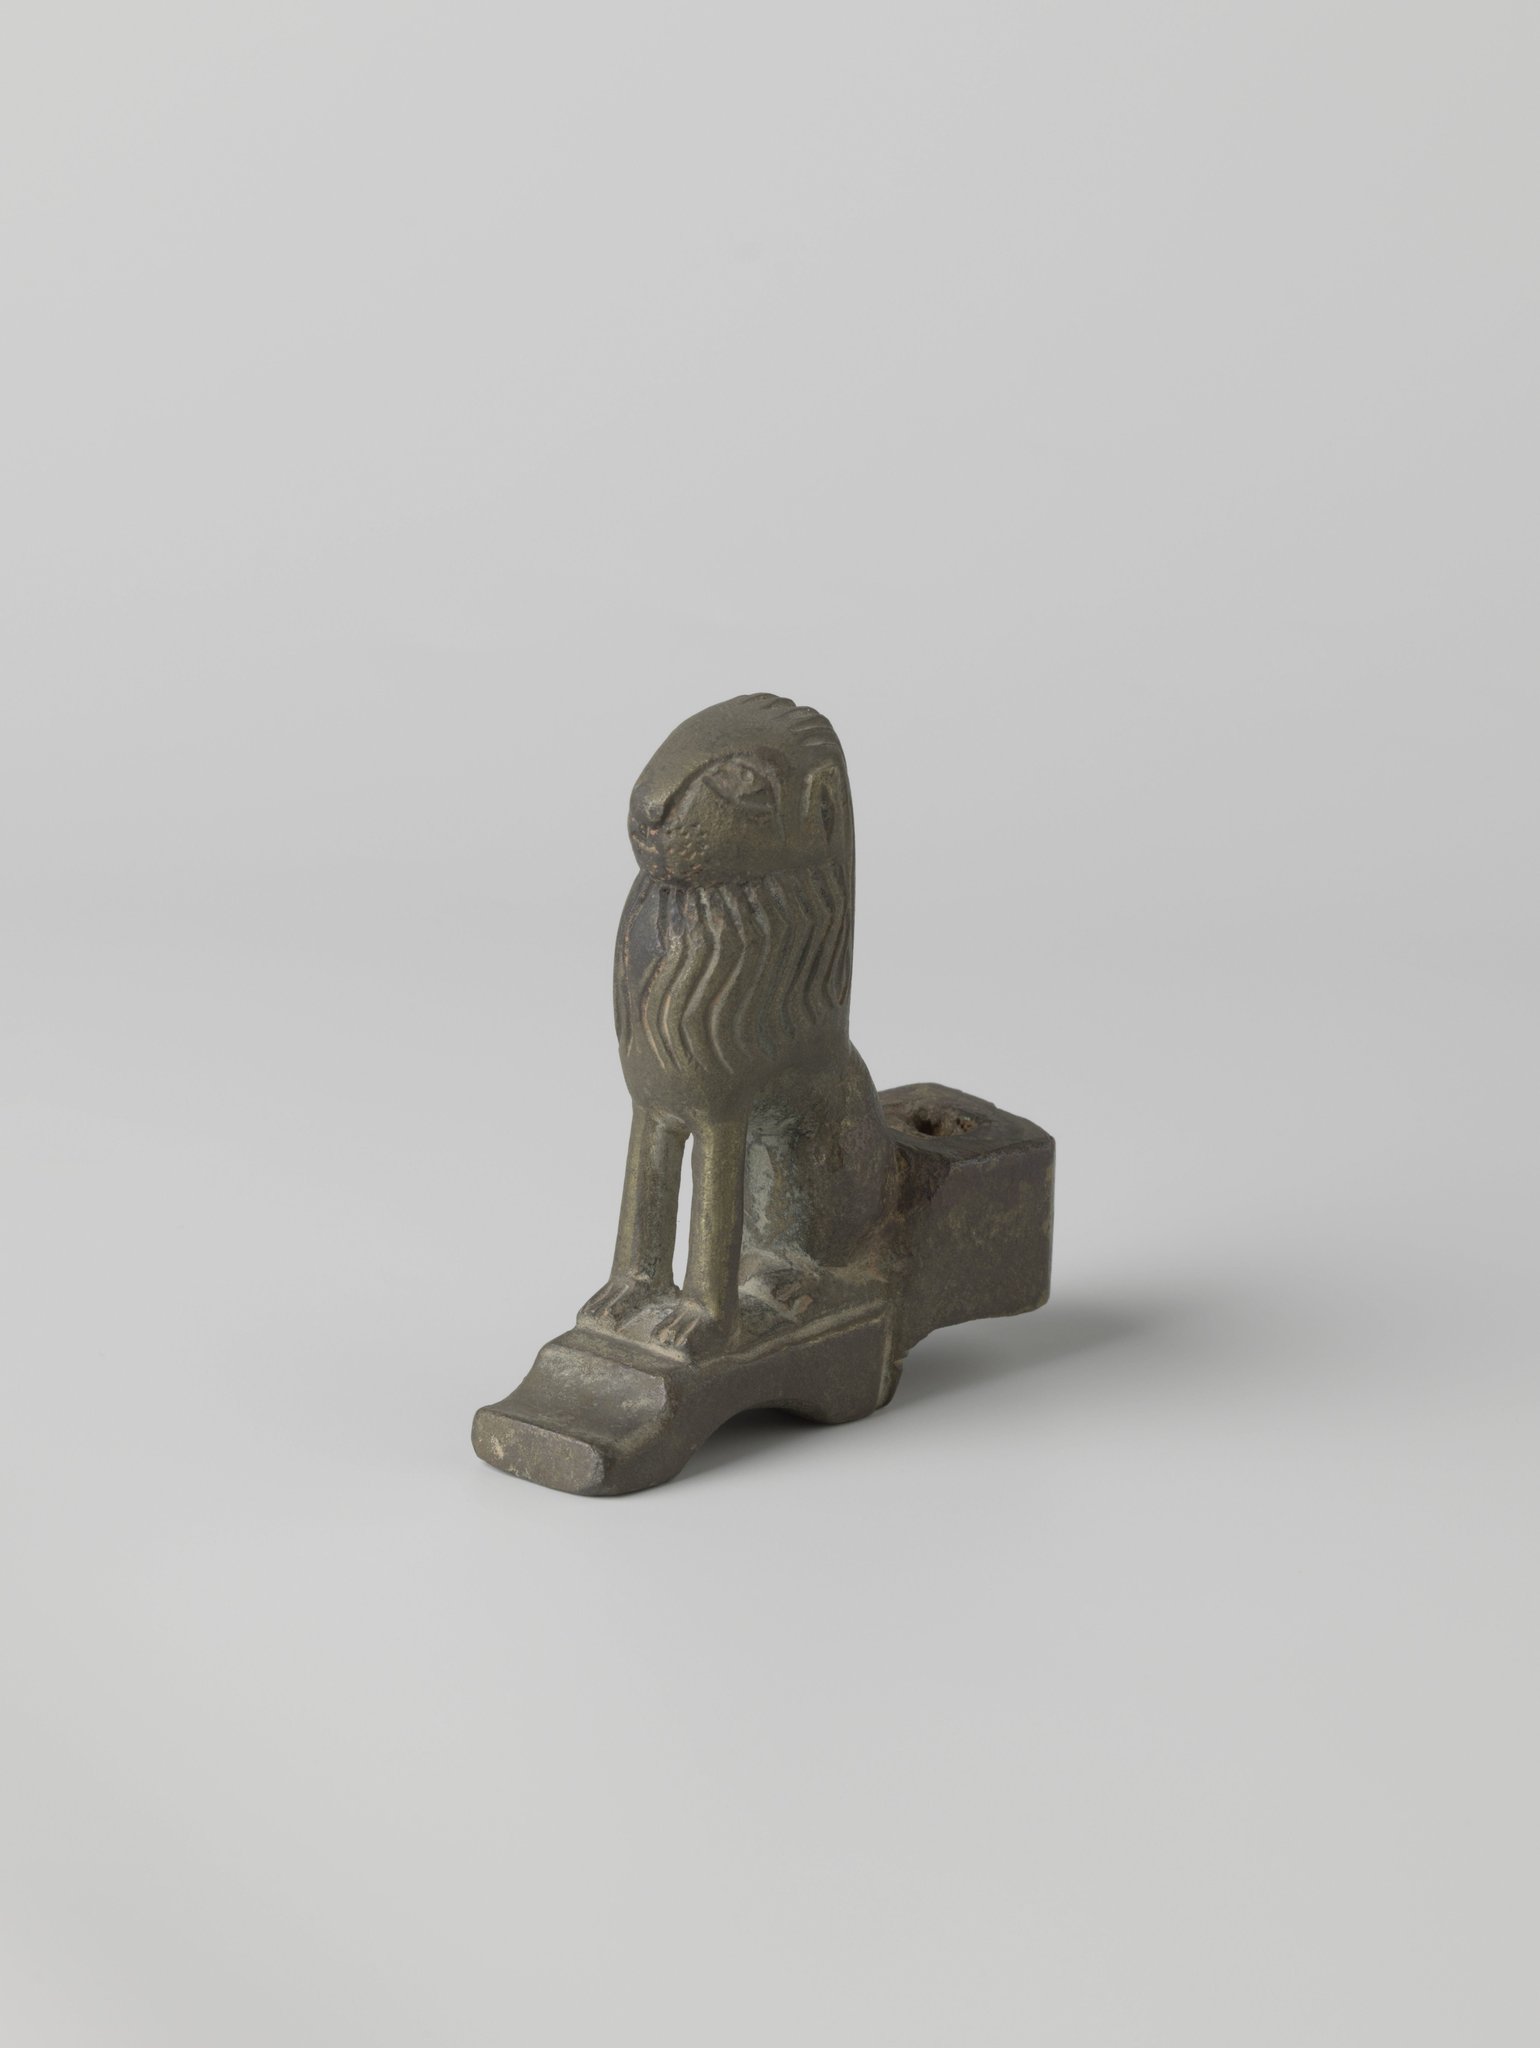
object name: candlestick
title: Voet van een kandelaar met zittende leeuw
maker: Anonymous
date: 1400-1500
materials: brass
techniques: casting, metalworking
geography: northern netherlands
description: Voet van een kandelaar. Het als geheel gegoten en bijgeciseleerde voorwerp bestaat uit een met een zittende leeuw versierde voet en een vierkant gedeelte, waarin de vierkante pin kan worden geklonken ter bevestiging aan de kandelaar.